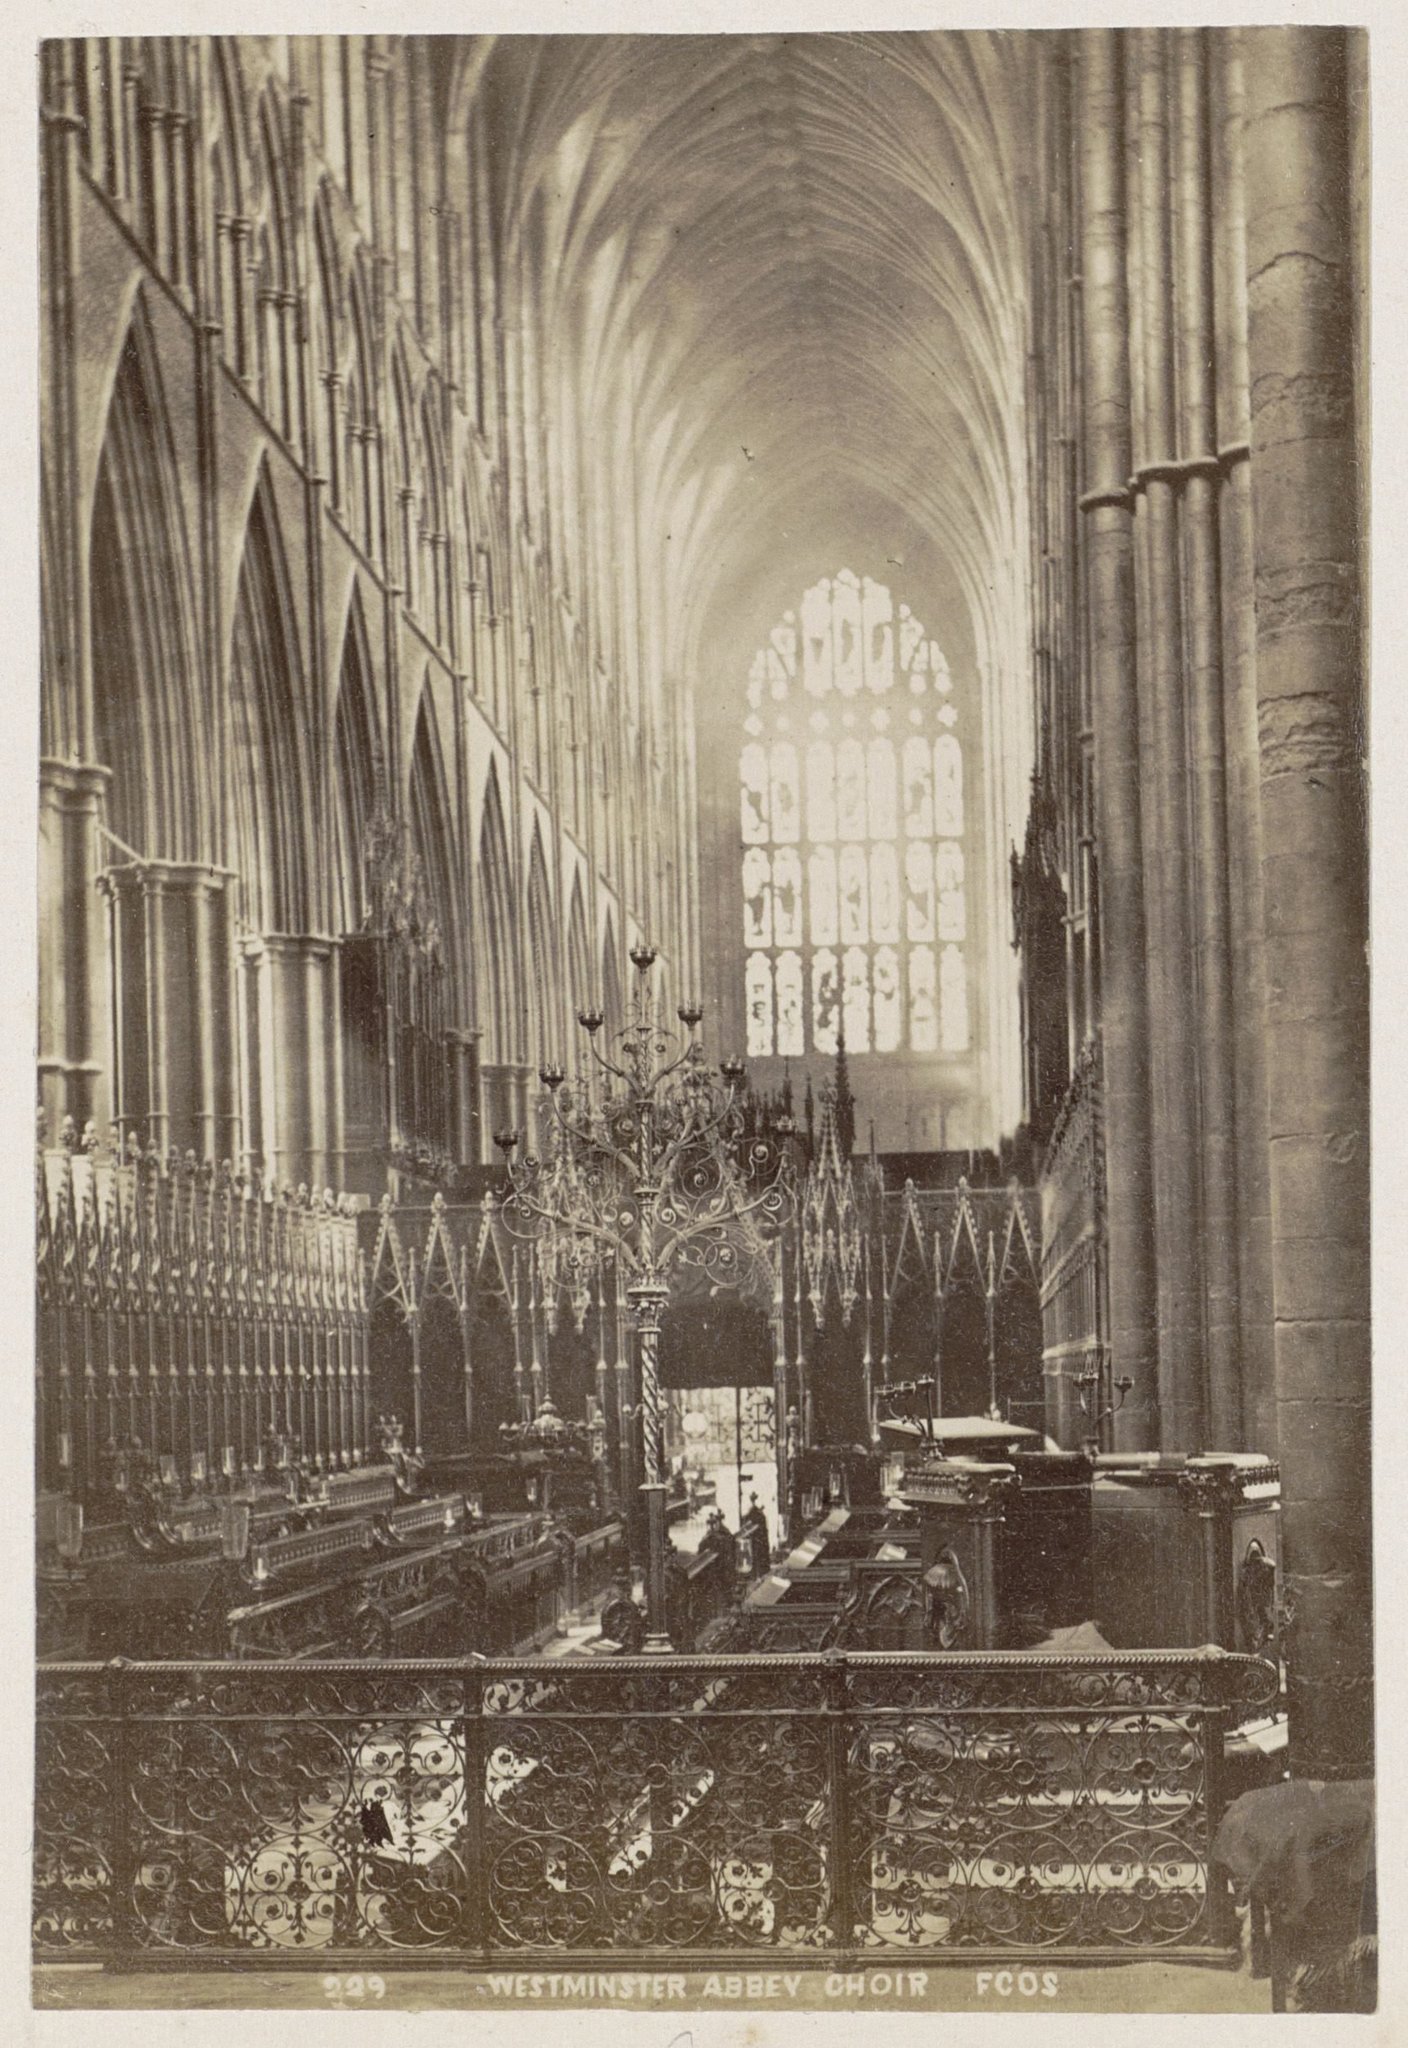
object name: photograph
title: Interieur van Westminster Abbey in Londen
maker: francis godolphin osbourne stuart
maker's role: fotograaf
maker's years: 1843-1923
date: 1878-1890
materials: photographic support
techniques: albumen print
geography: london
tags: protestant churches and denominations, exterior ~ representation of a building, westminster abbey, london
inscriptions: negative number: ‘229’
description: Onderdeel van Reisalbum Europese steden, vermoedelijk Zweeds.